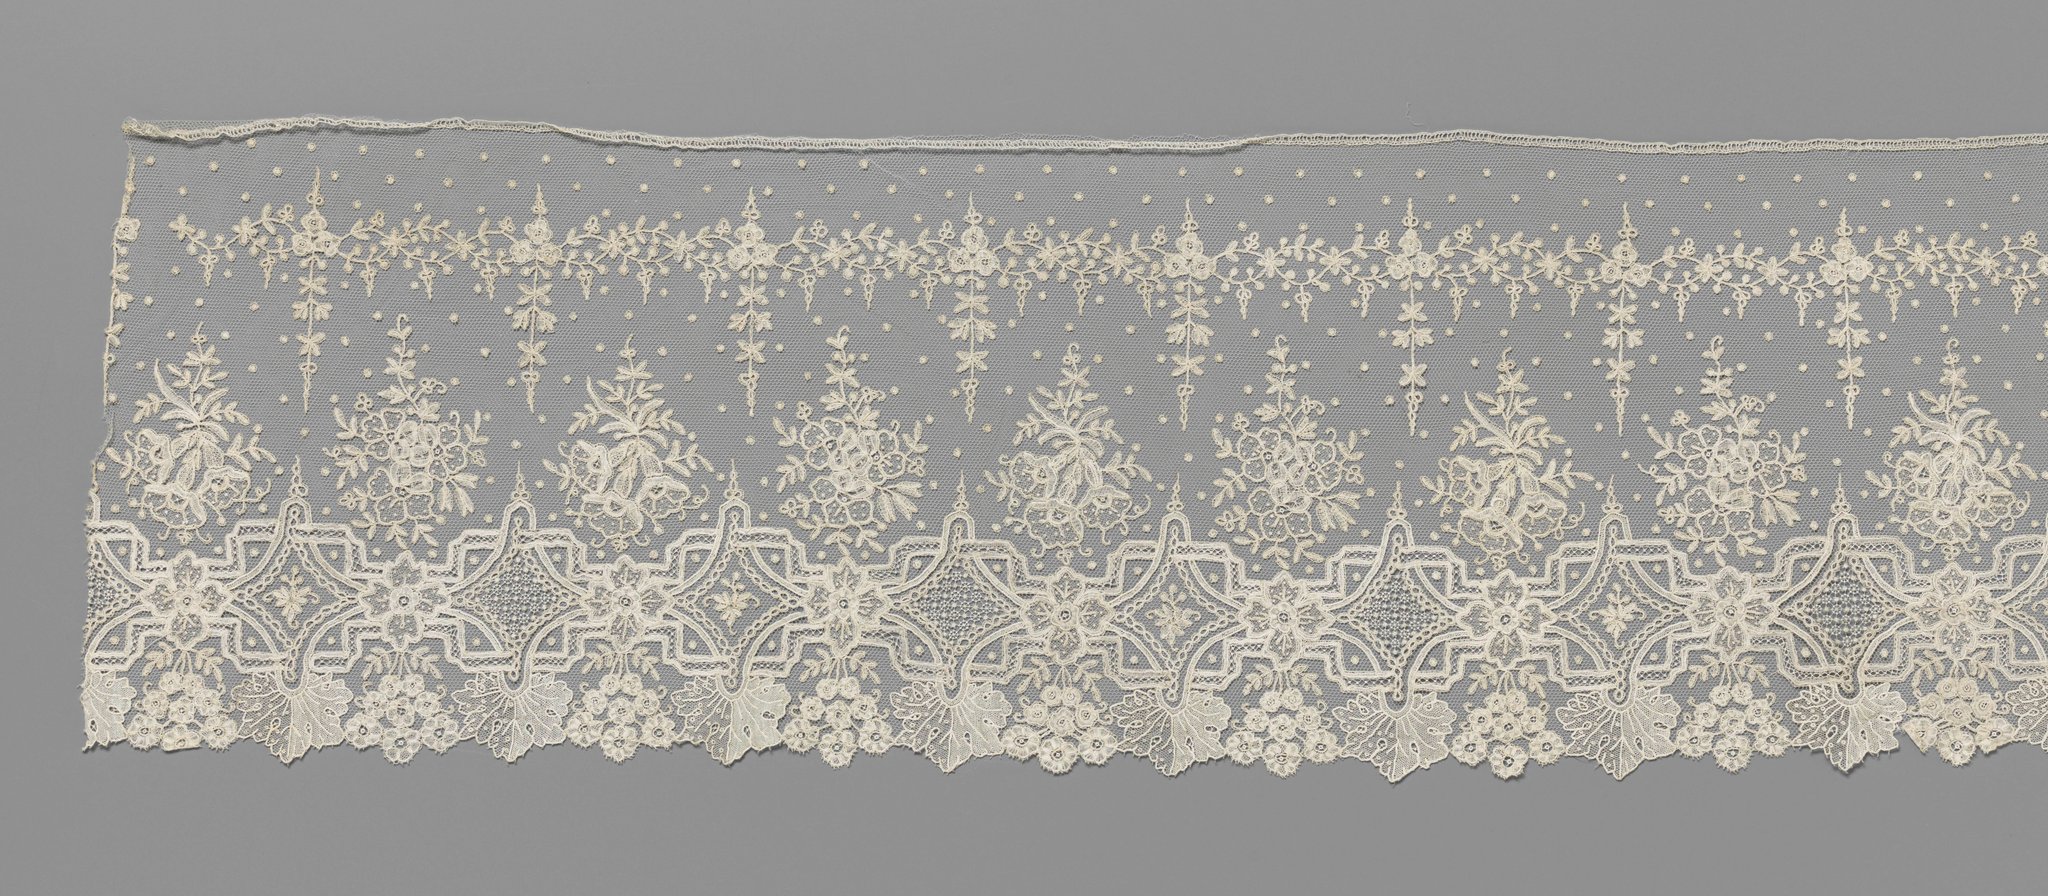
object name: strip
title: Japonstrook van applicatiekant met schakelrand van geometrische vormen en rozetbloemen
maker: Anonymous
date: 1850-1880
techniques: lace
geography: brussels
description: Japonstrook van Brusselse applicatiekant, kloskant en naaldkant -Brusselse gaaskant - geappliceerd op machinale tule. Strooipatroon met moesjes en een naar de schulpenzijde in dichtheid toenemend patroon. Langs de bovenzijde loopt een luchtige guirlande, die bestaat uit een dubbele, kruisende golflijn, die steeds wordt onderbroken door drie rozetjes met een recht afhangend bladrankje. Daaronder een zich herhalend patroon van een los staande bloemtak, afwisselend van drie rozetbloemen en drie hangende bloemen. Onderaan loopt een schakelrand met geometrische vormen, vierkantjes door ruitjes oversneden, die door een grote rozetbloem aan elkaar gekoppeld zijn. Onder elke ruit hangt een wijnblad en onder elke grote rozetbloem een tros kleine rozetbloempjes. Deze wijnbladeren en trossen rozetbloempjes vormen de ondiepe schulpen langs de onderrand. De bovenkant is afgewerkt met een randje kloskant.